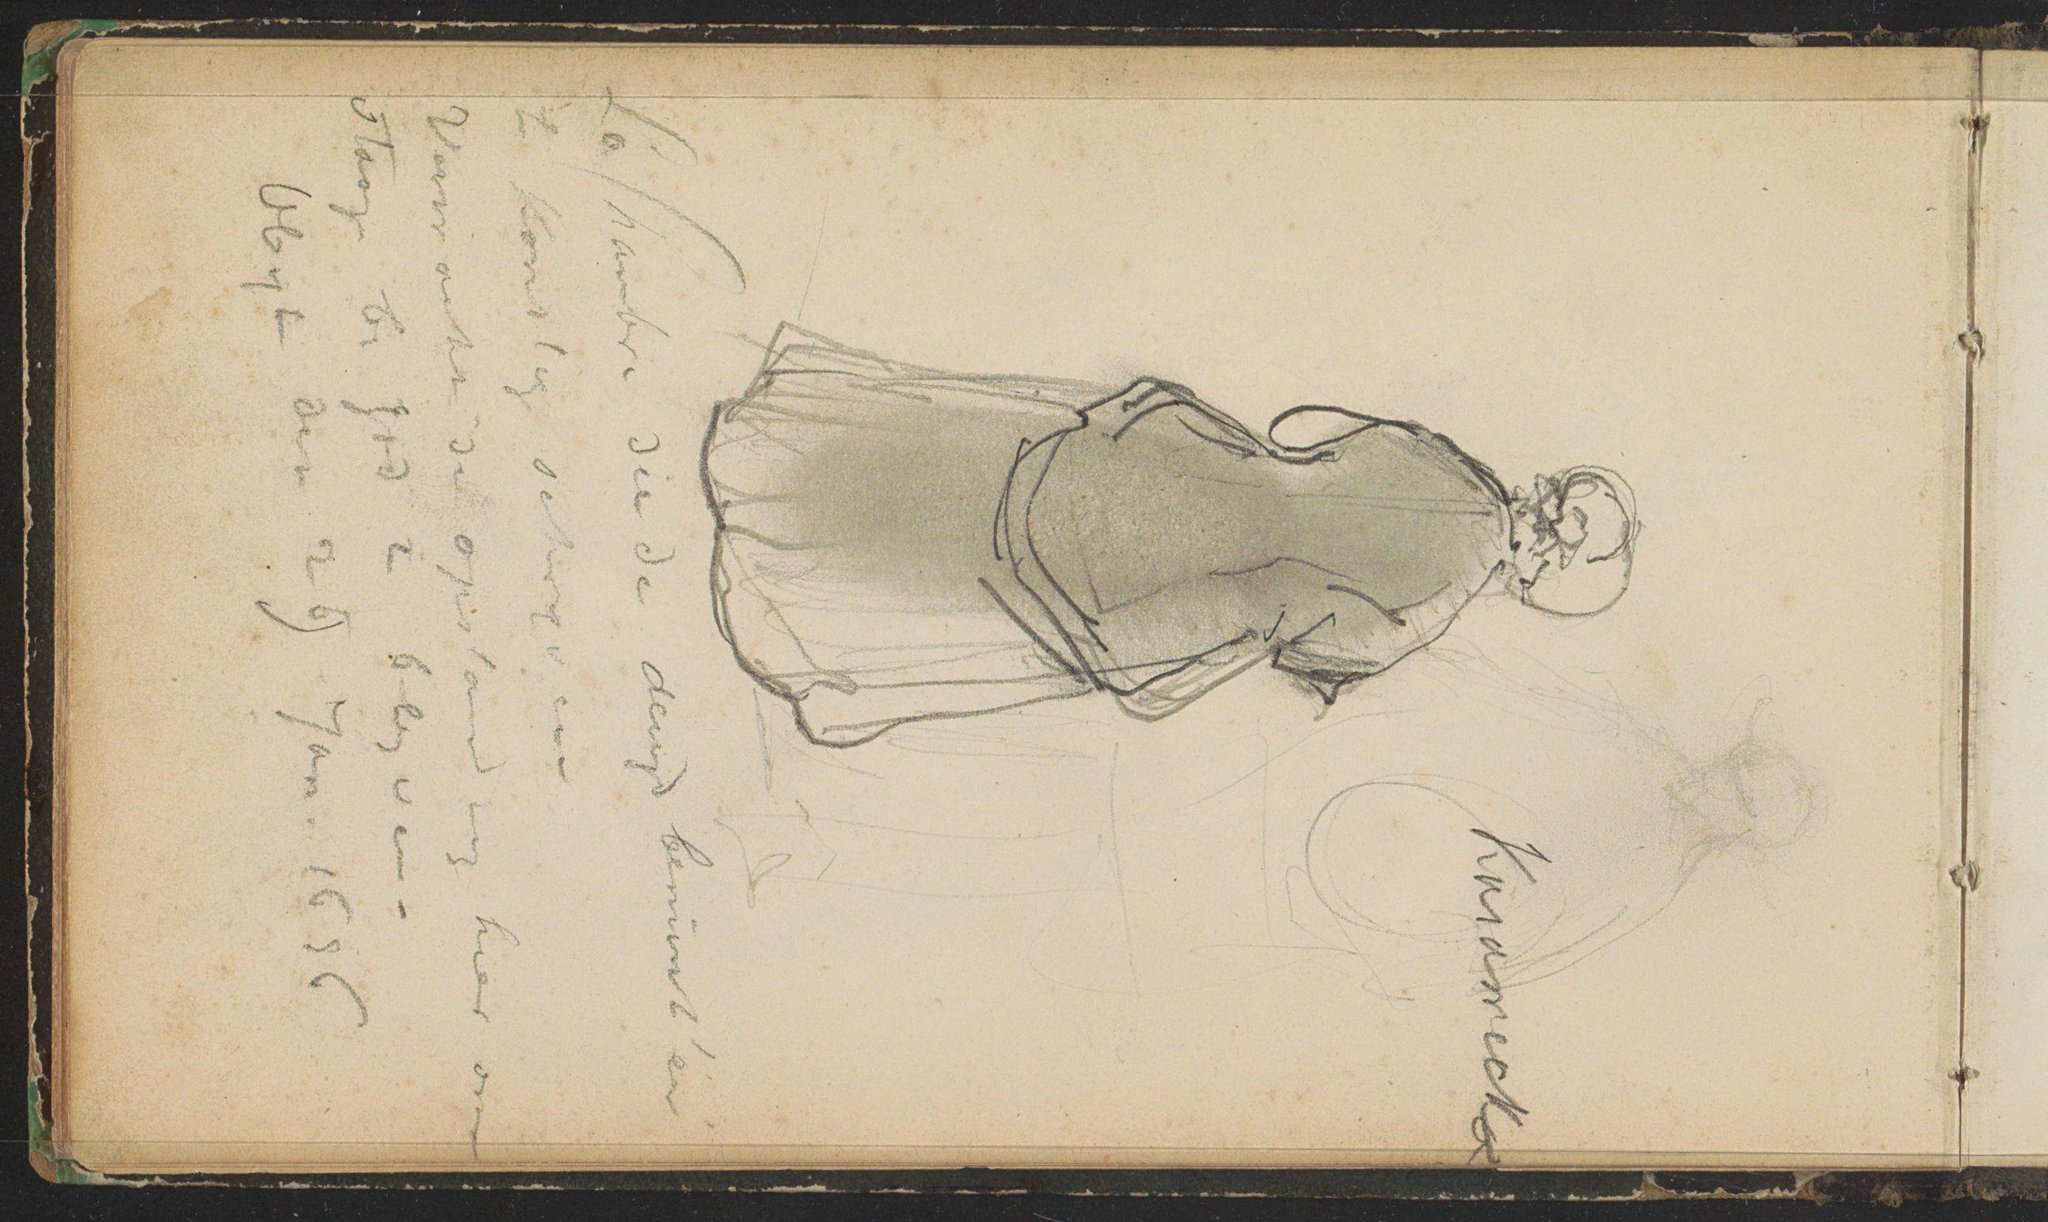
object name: sketchbook leaf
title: Vrouw met een mantel en hoed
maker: johannes bosboom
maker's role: draughtsman, painter, print maker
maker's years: 1817-1891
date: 1845-1891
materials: paper, pencil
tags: coat (+ women's clothes)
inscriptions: annotation: ‘Karameck[..]/ La chambre [...]ie de deugd bemint en/ 't konstig schrijven/ Va[...] op land wij hier om/ slaap b[...] god te blijven/ Obyt den 29 Jan, 1656’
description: Blad 46 verso uit een schetsboek met 46 bladen.